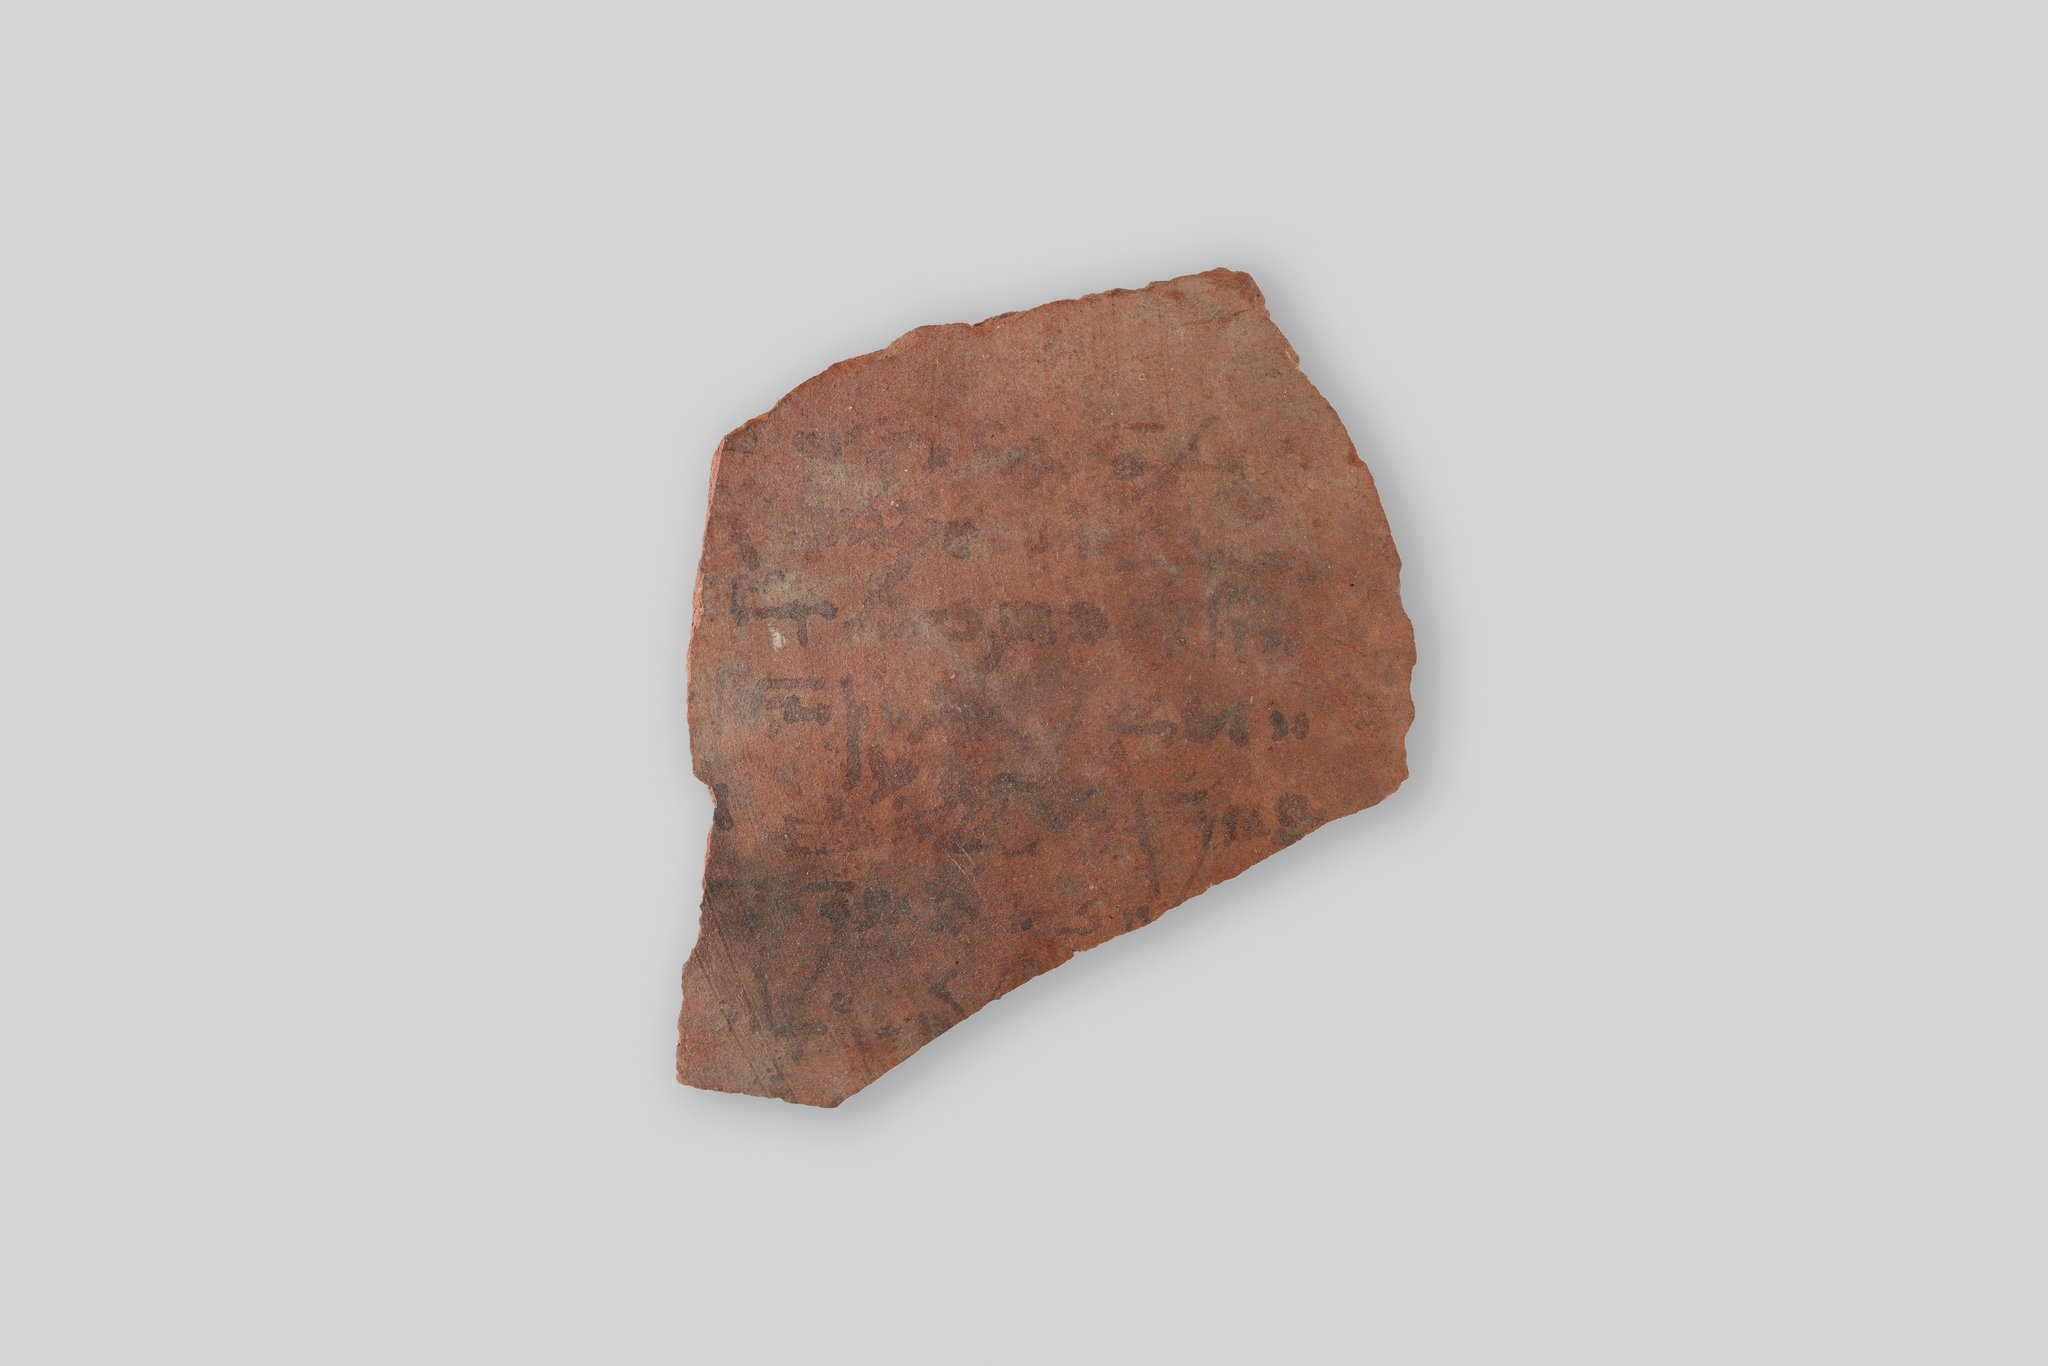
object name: ostracon, demotic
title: Ostracon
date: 600-30 BCE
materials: ink, pottery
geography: egypt